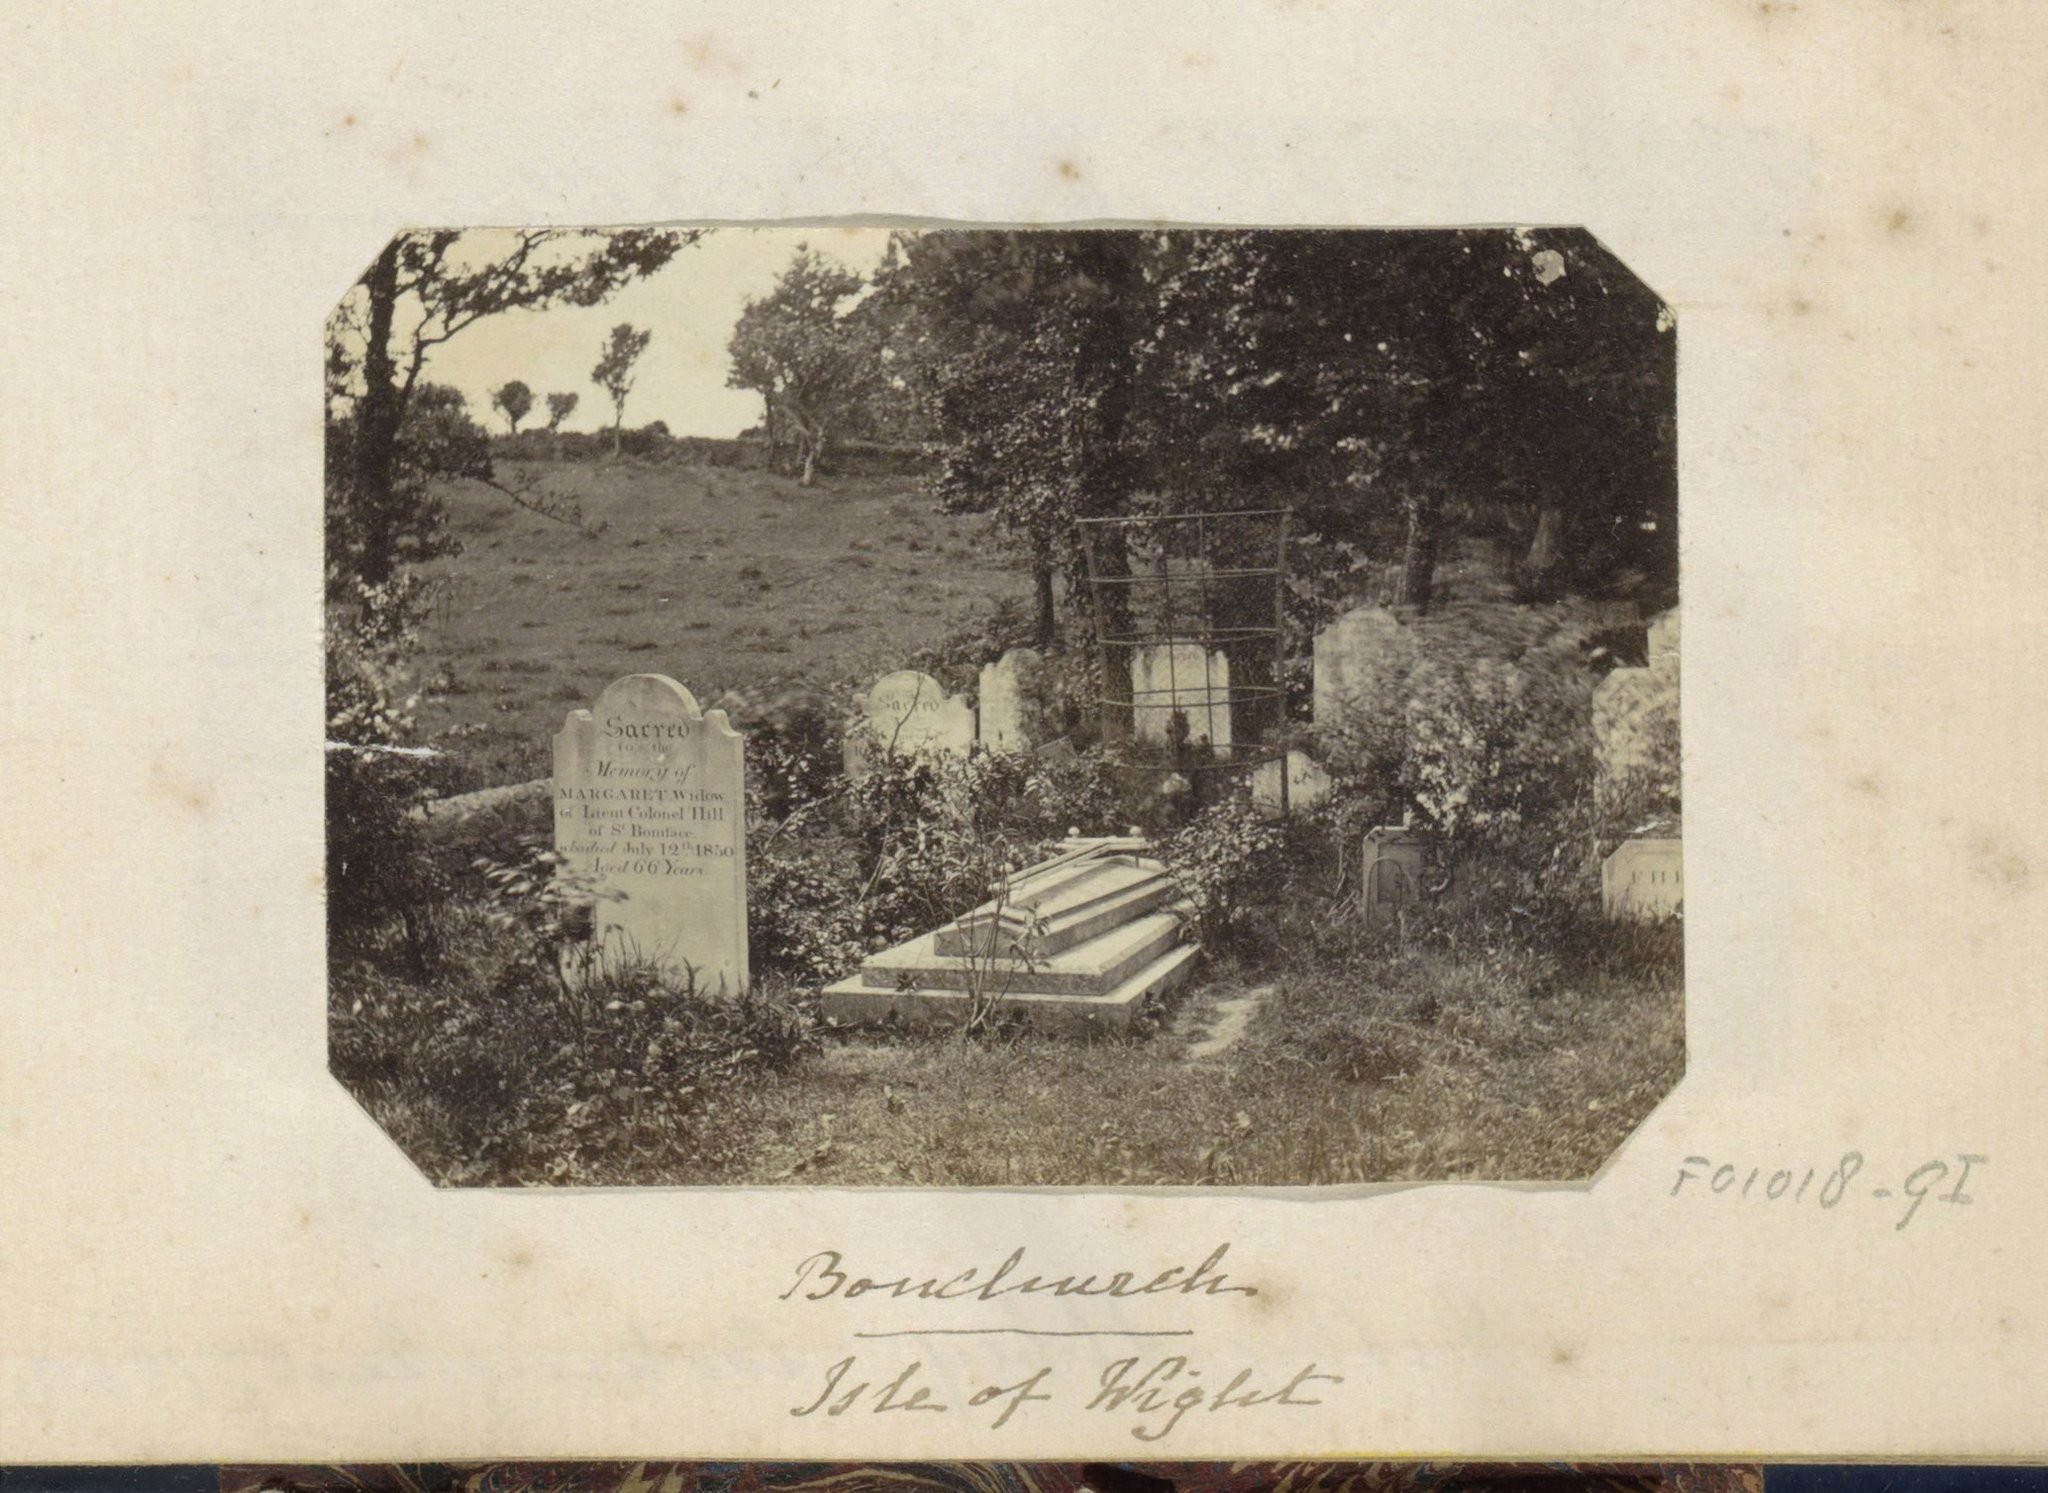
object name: photograph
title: Grafstenen en tombe op de begraafplaats van Bonchurch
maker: Anonymous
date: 1860-1870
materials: paper, photographic support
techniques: albumen print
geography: bonchurch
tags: grave, tomb, gravestone, tombstone, churchyard, cemetery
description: Onderdeel van Engels familiealbum met foto's van personen, reizen, cricket en kunstwerken.